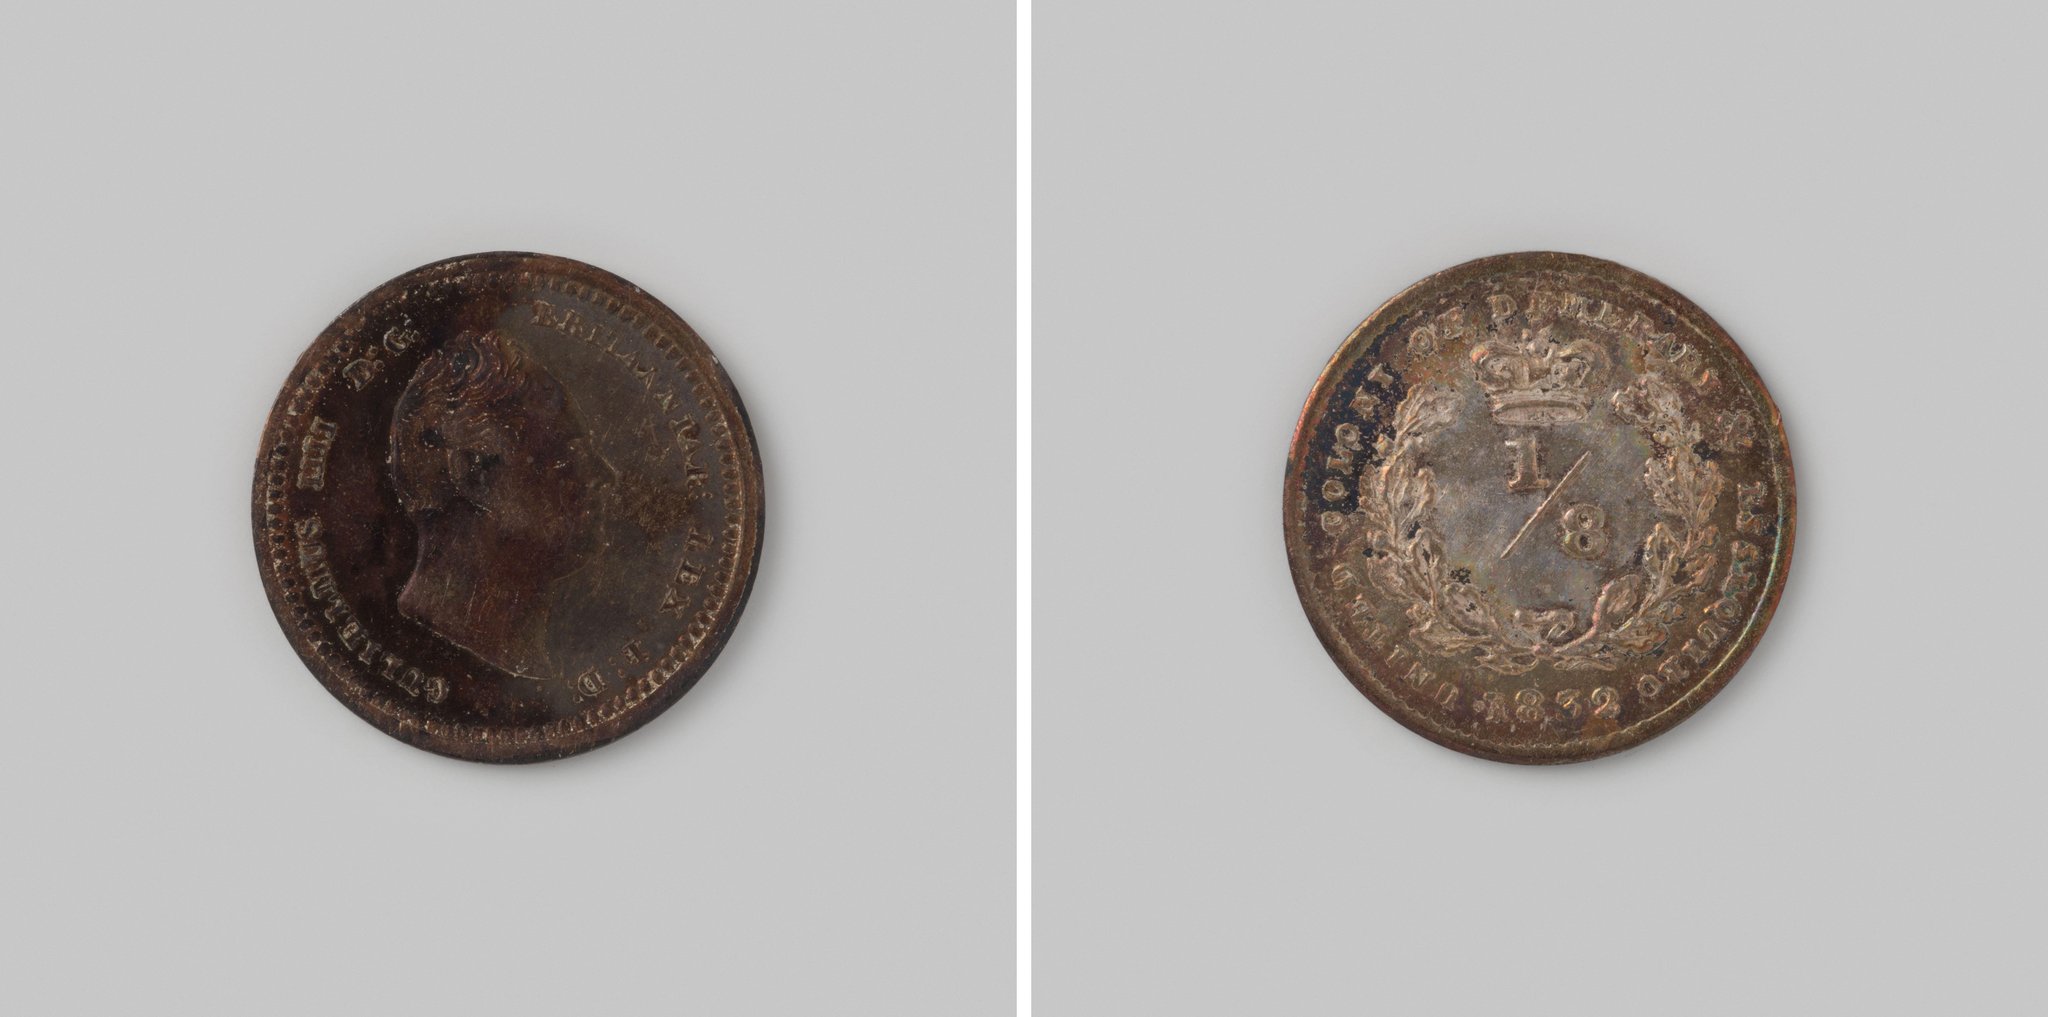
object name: coin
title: 1/8 guilder uit Essequibo & Demarary van koning Willliam IV, 1832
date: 1832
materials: silver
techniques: striking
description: Zilveren munt. Voorzijde: hoofd van de koning naar rechts. Keerzijde: tussen twee samengebonden takken waarde-aanduiding: 1/8, waarboven kroon. Jaartal onderaan in omschrift. Gladde rand.